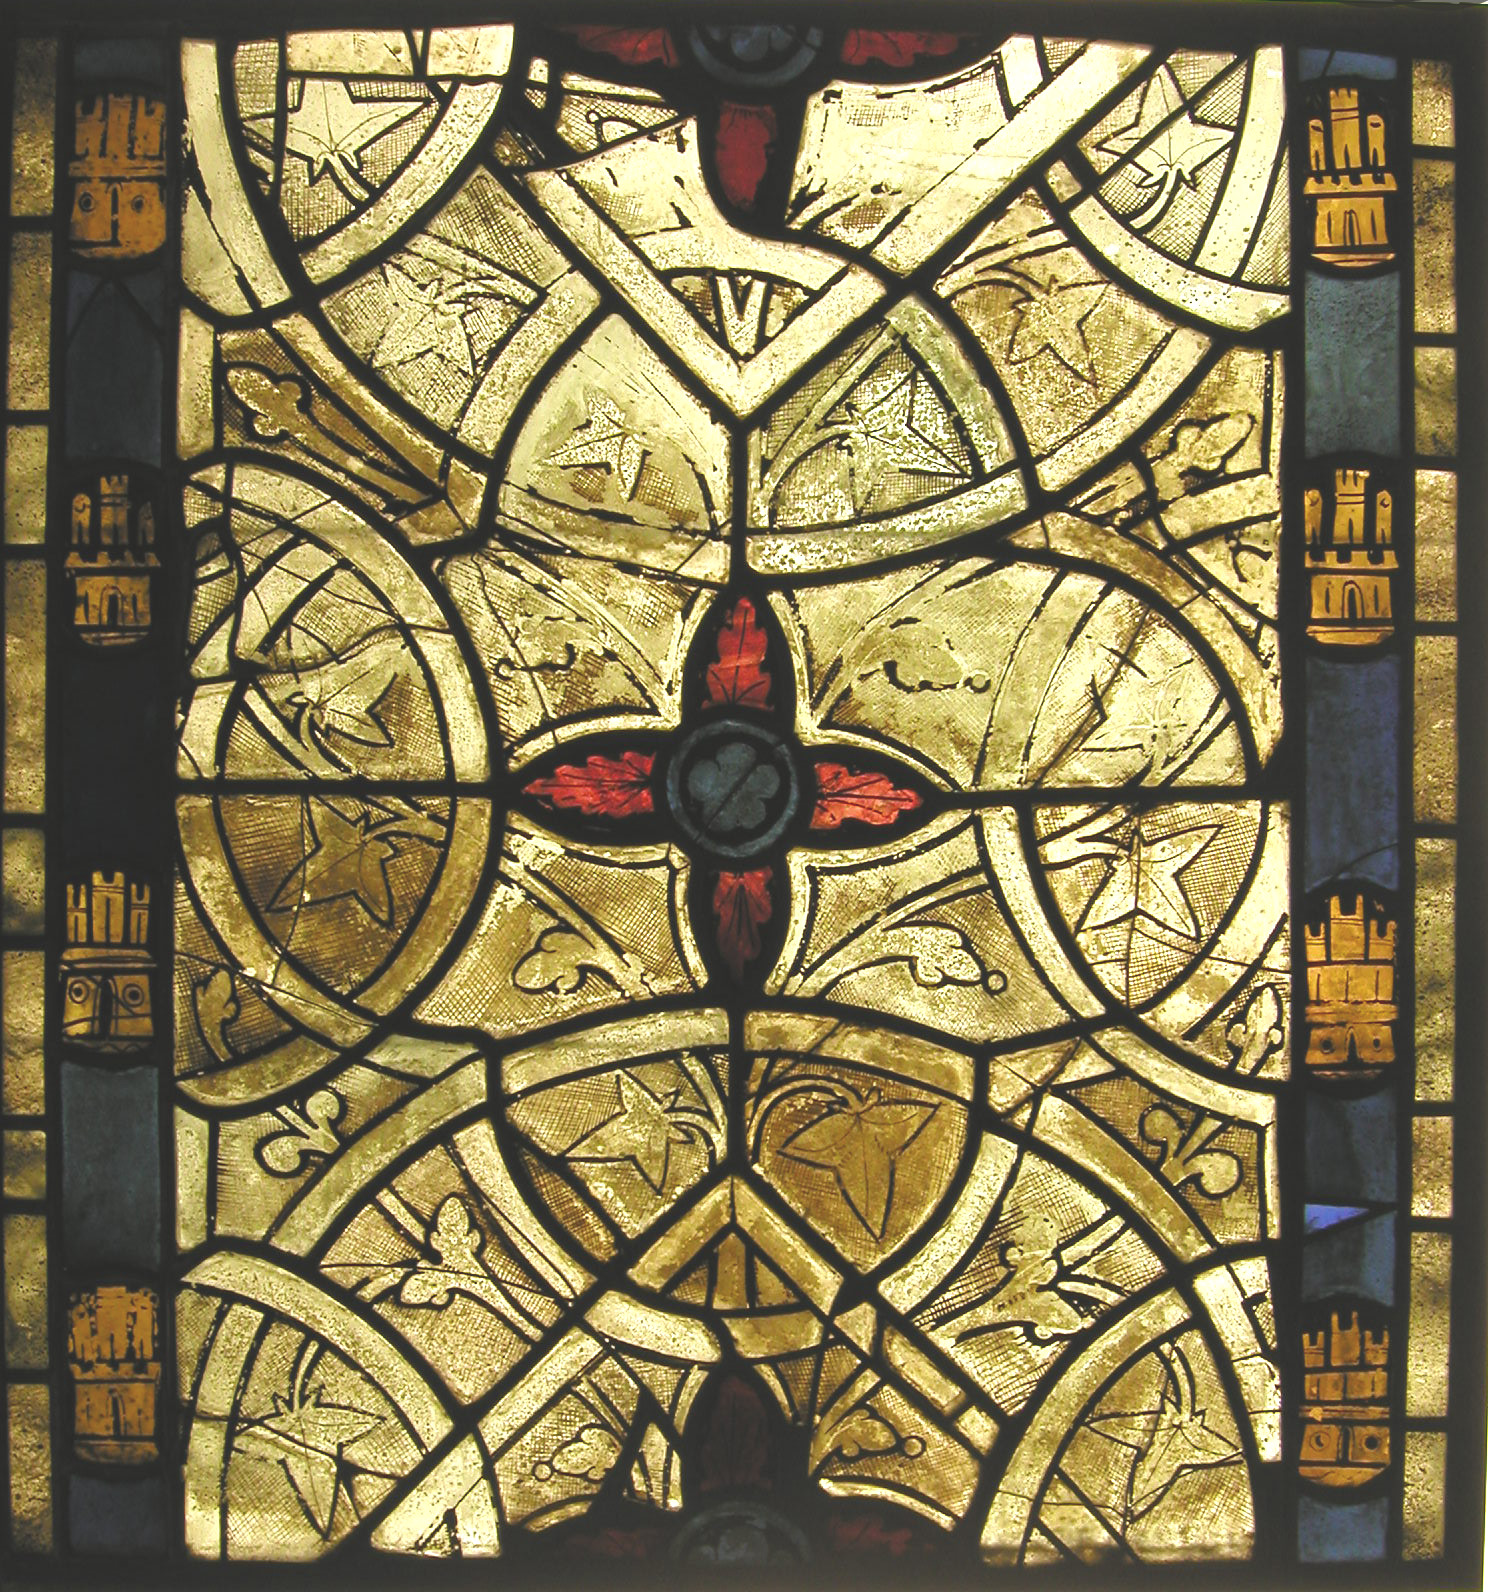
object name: panel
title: Grisaille Panel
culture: french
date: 1265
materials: glass, metal, paint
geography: france